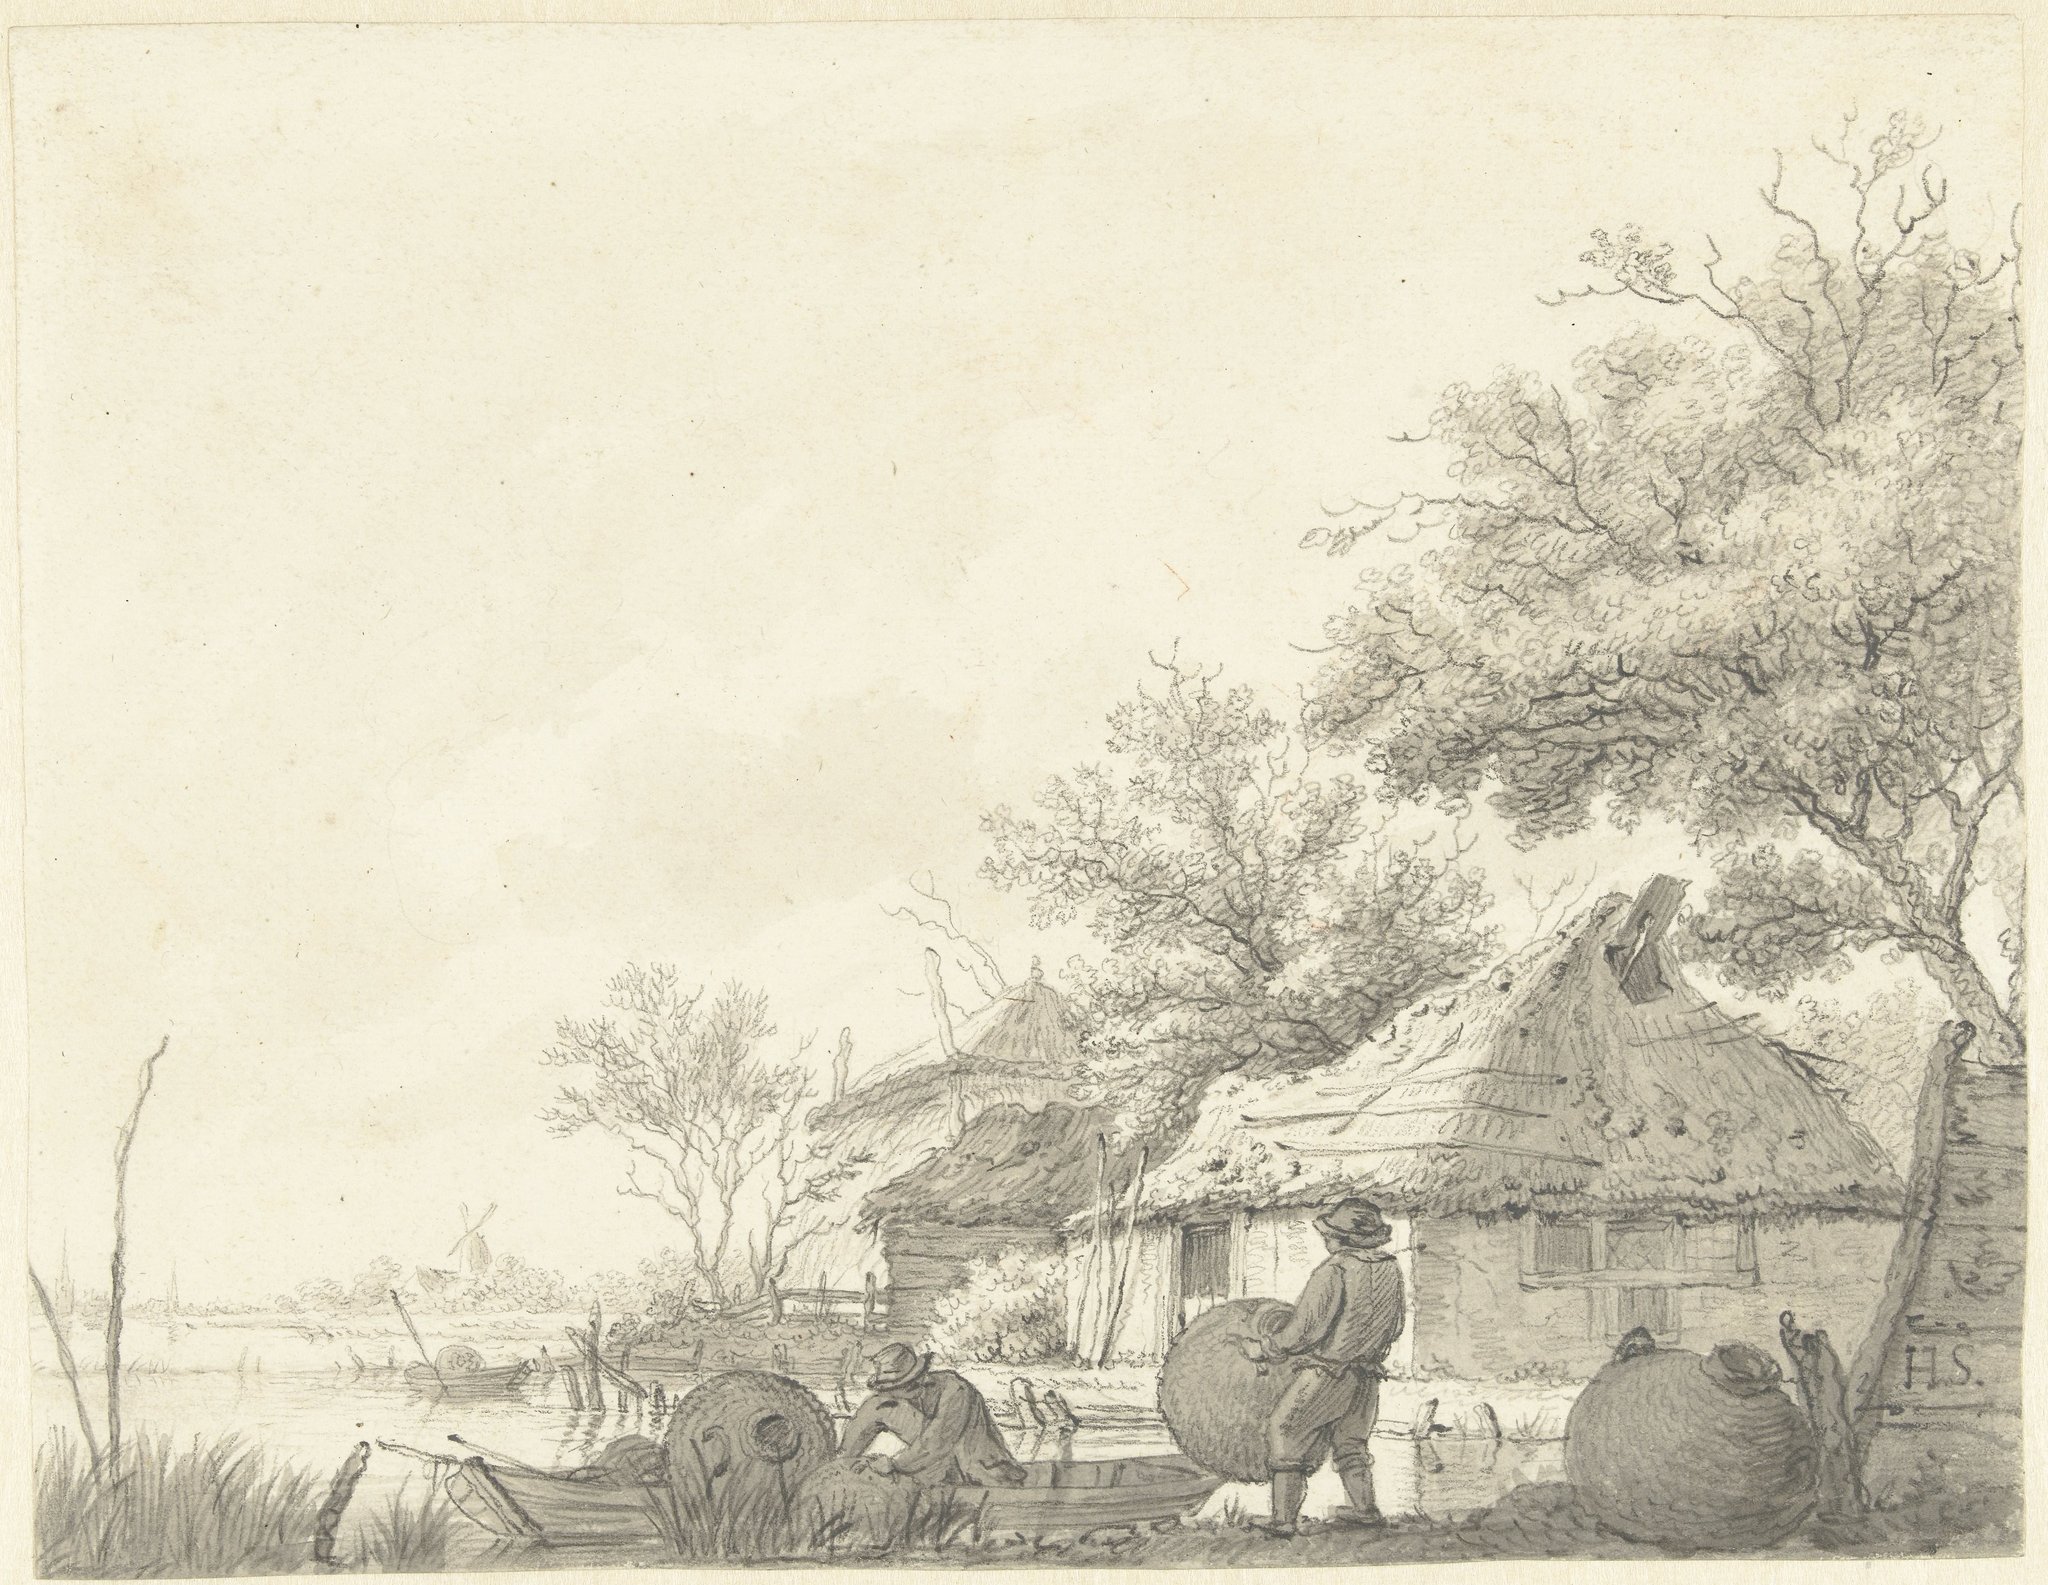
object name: drawing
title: Twee vissers met korven bij een vaart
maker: hendrik schwegman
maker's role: draughtsman, print maker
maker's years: 1761-1816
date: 1771-1816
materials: chalk, paper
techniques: brush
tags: fresh-water fishery, small canal, ditch, farm or solitary house in landscape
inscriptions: inscription: ‘H.S.’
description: Twee vissers met grote rieten korven bij een vaart; op de achtergrond een boerderij met hooiberg.